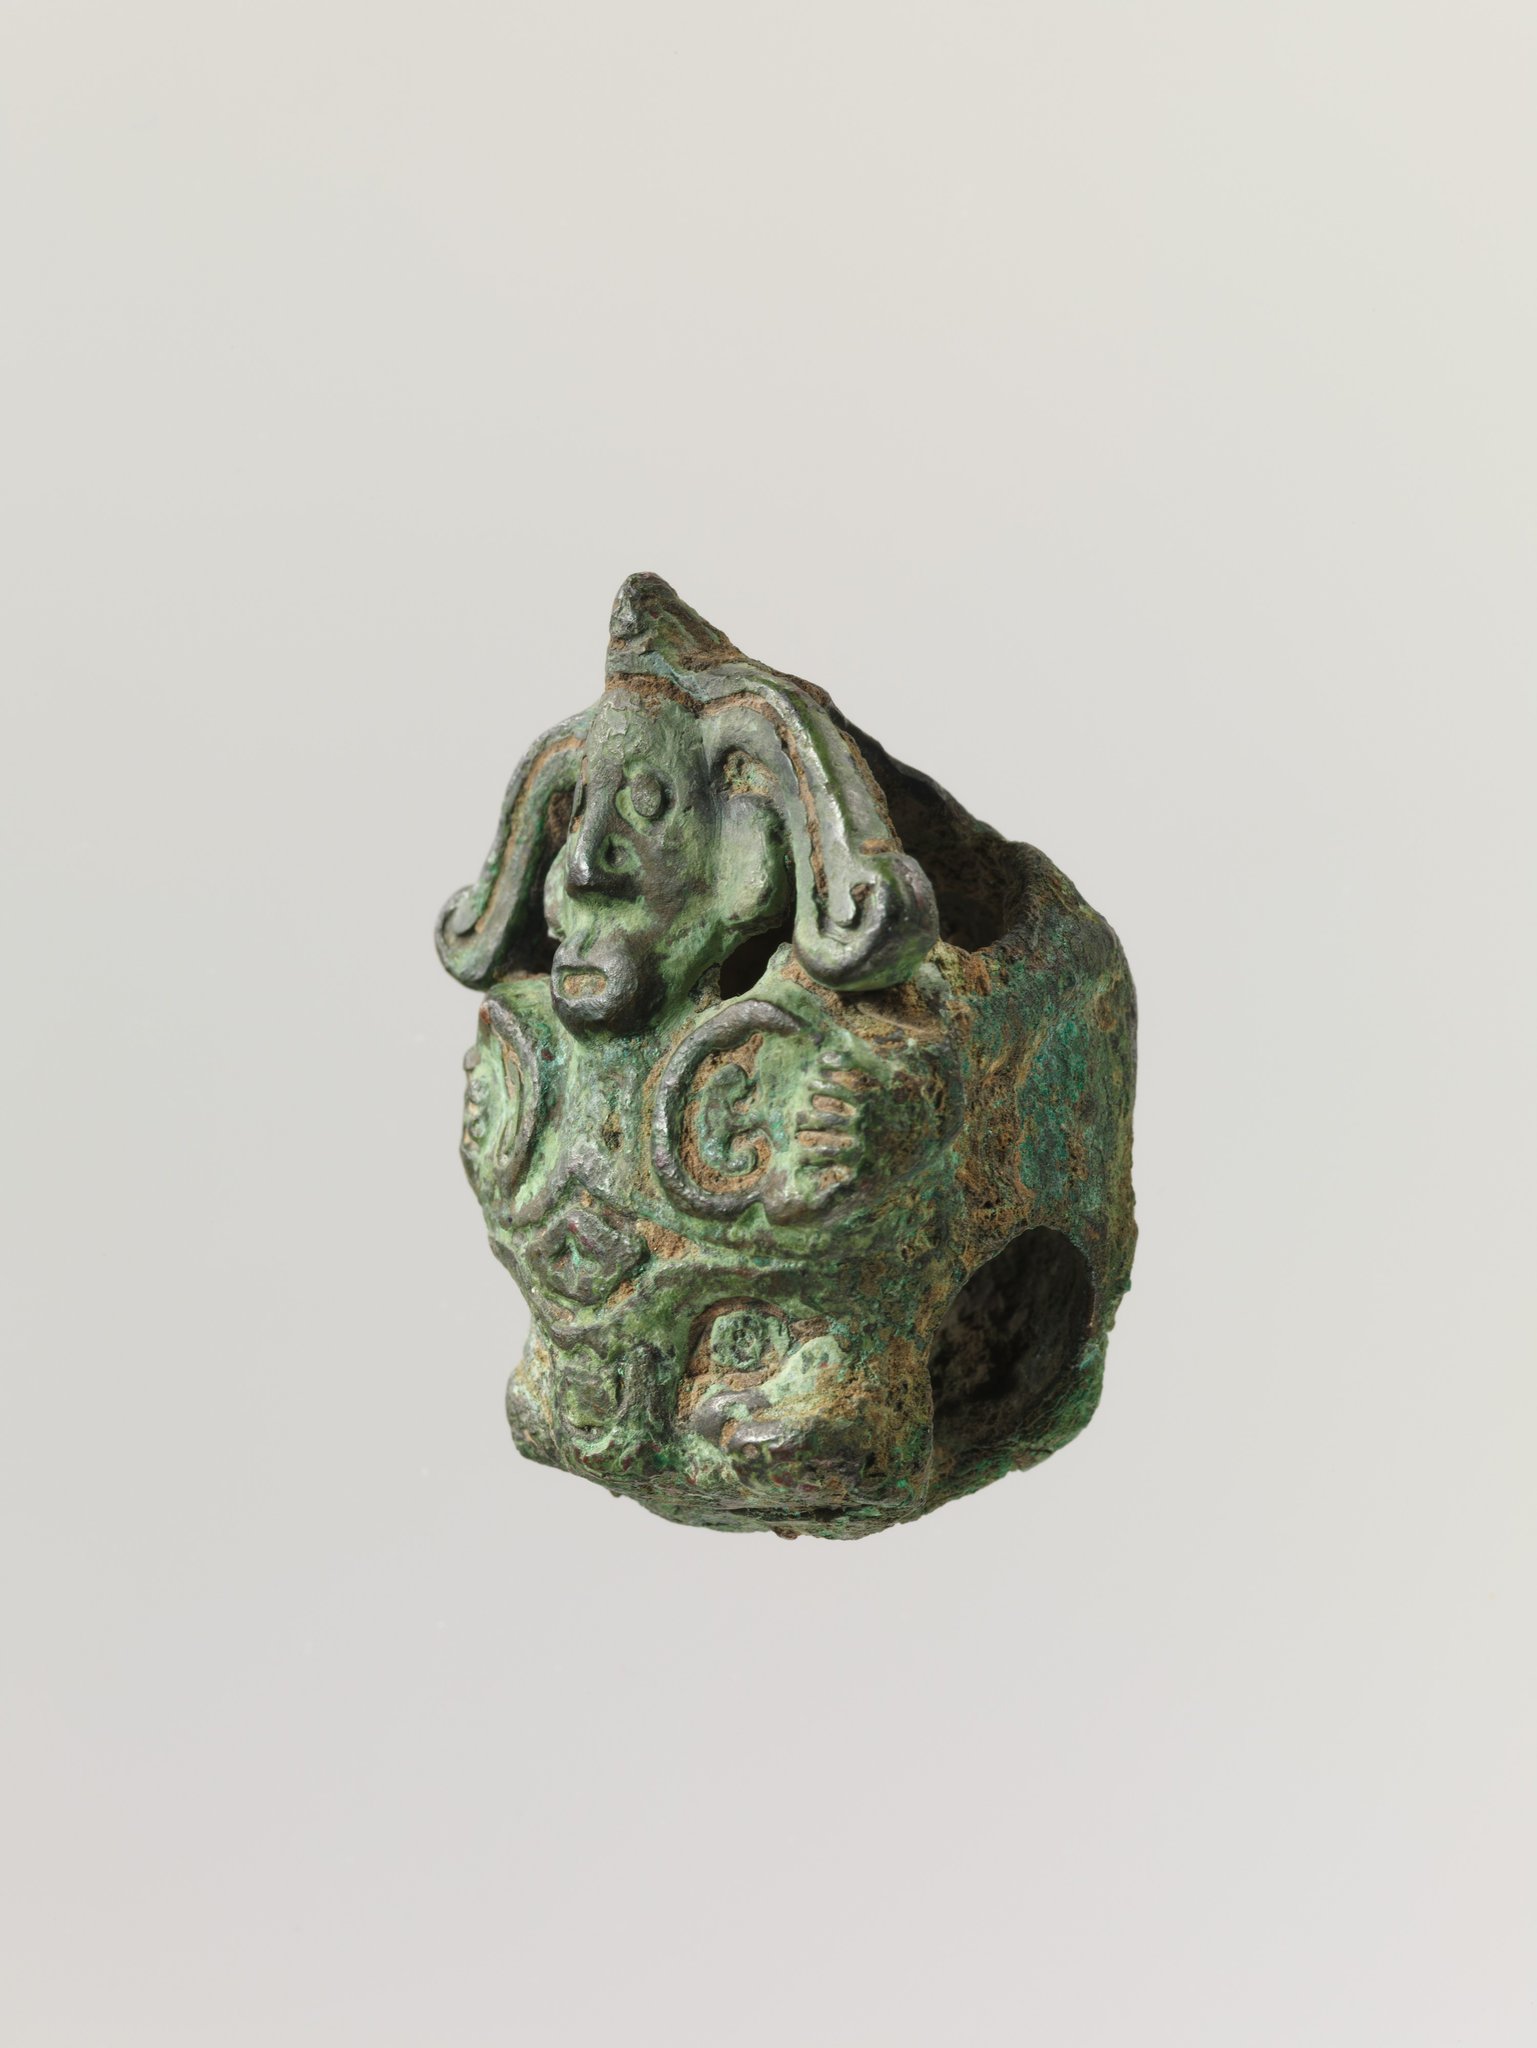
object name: fitting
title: Fitting in the shape of a man grasping a tiger head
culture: chinese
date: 1100-901 BCE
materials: bronze